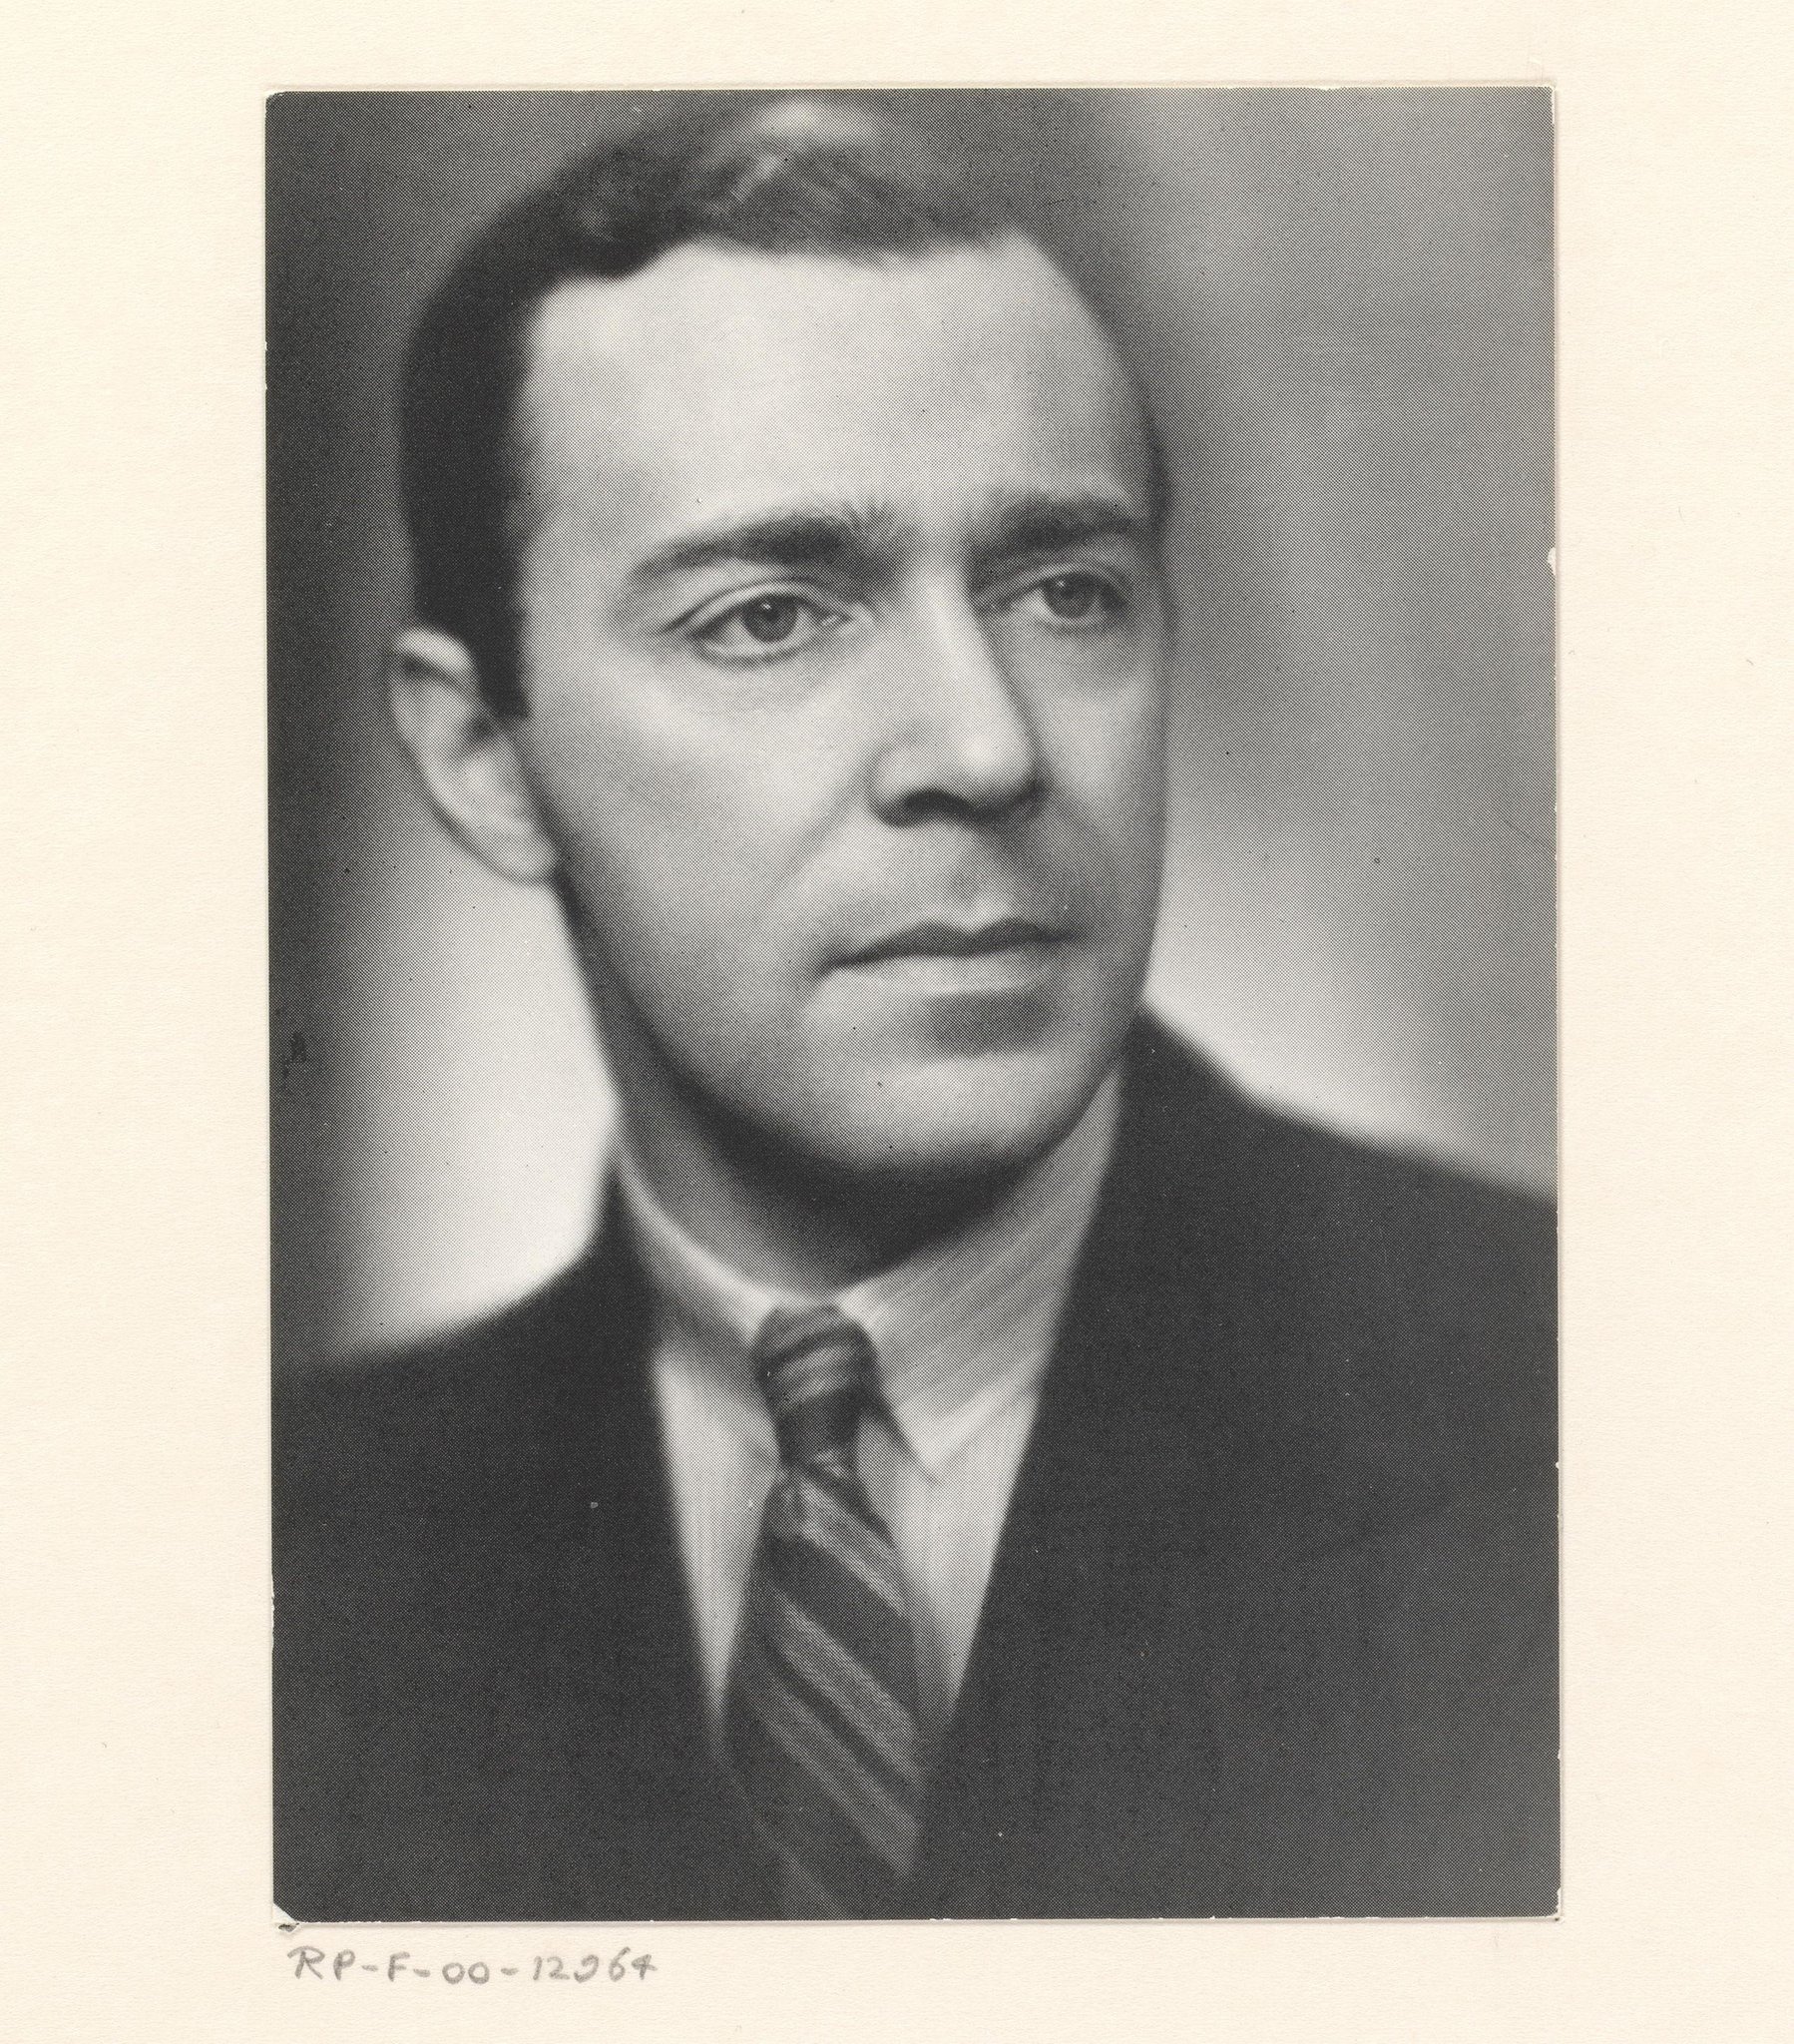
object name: ansichtkaart, prentbriefkaart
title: Prins Gustaf-Adolf (1906-1947), HM Konungens far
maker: Anonymous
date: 1945-1973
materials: cardboard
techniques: autotype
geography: strängnäs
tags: denmark, historical persons, crown prince